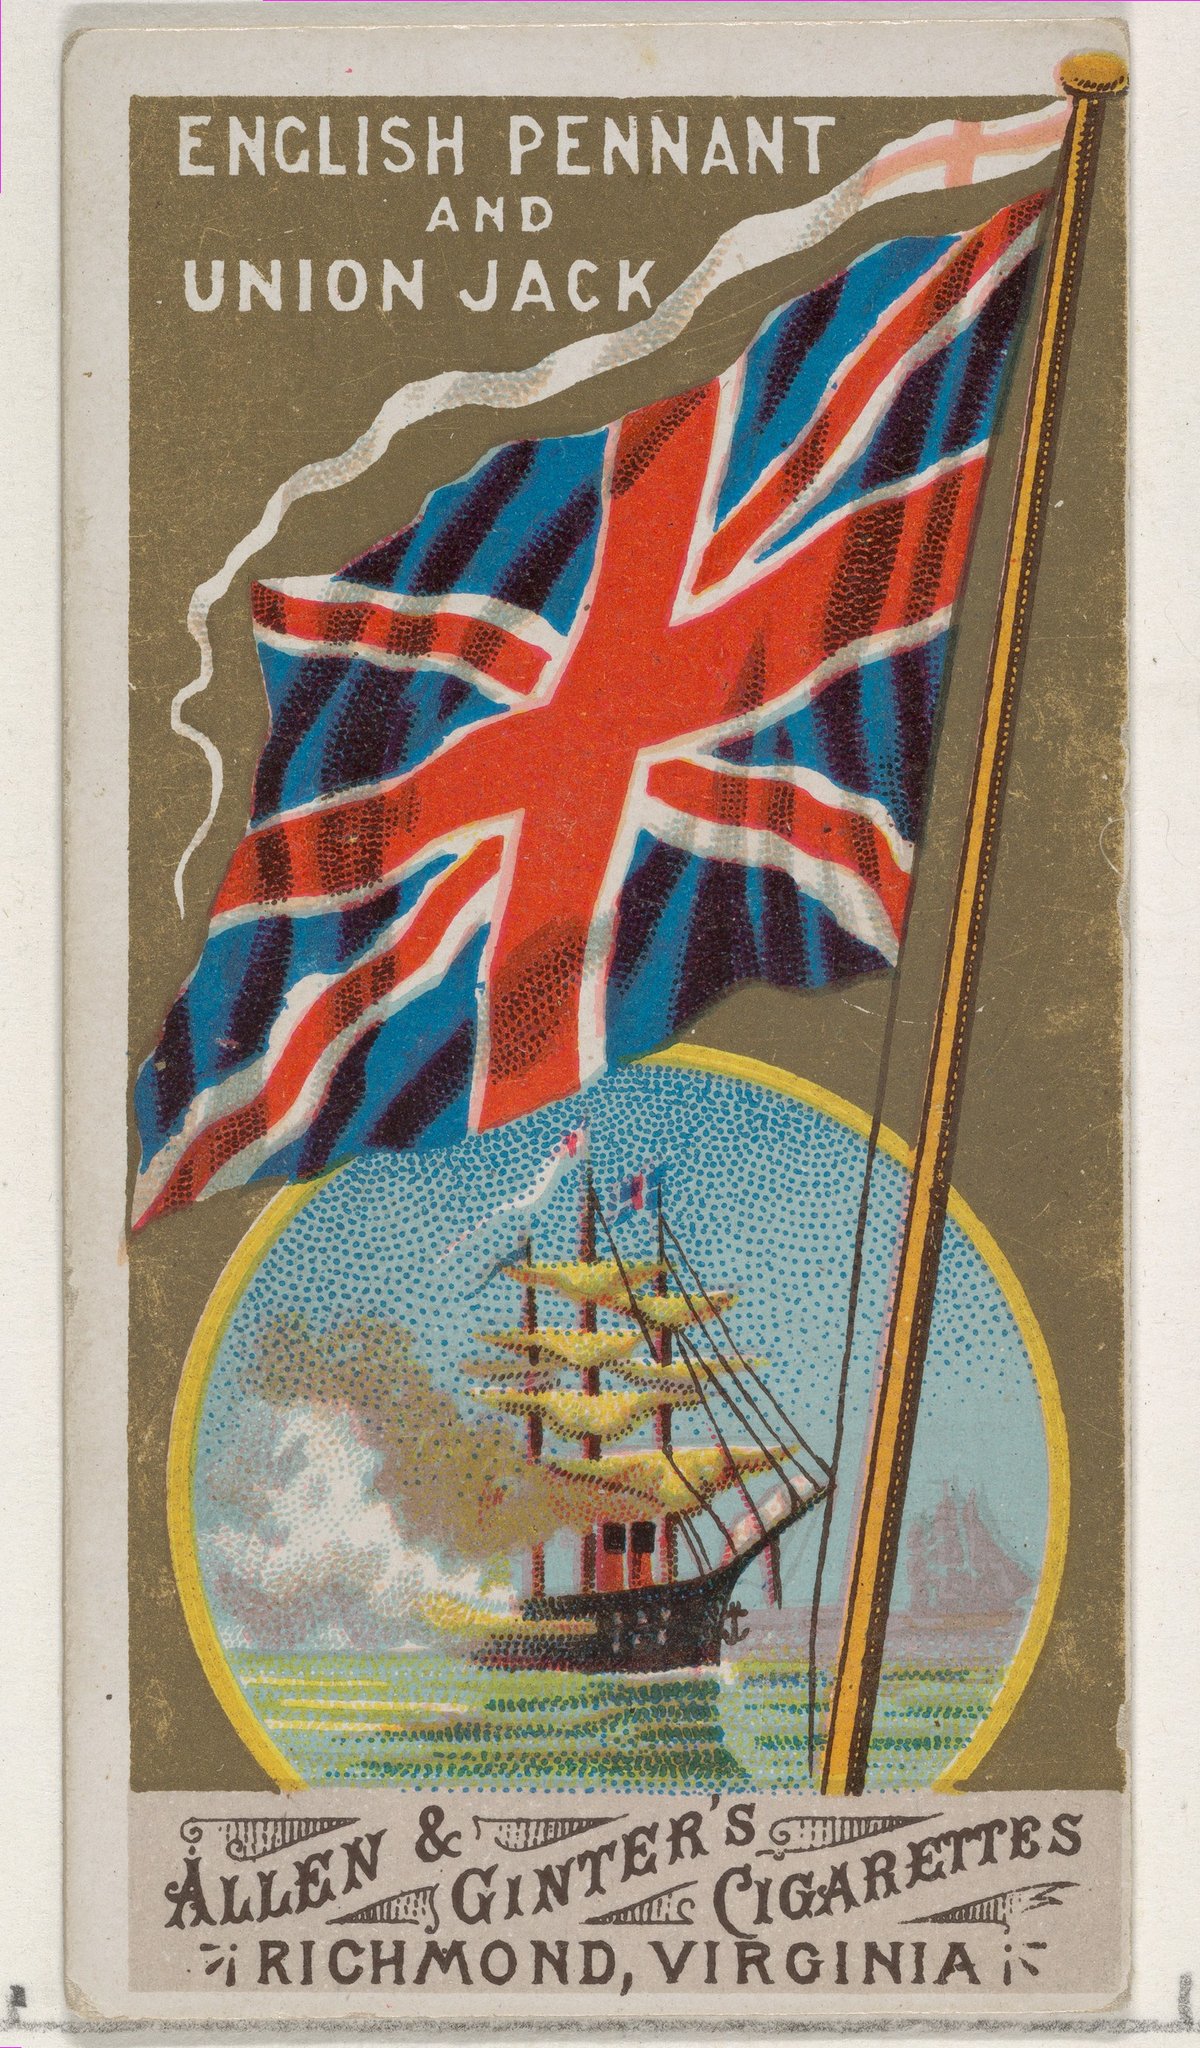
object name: print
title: Royal Standard, Great Britain, from Flags of All Nations, Series 1 (N9) for Allen & Ginter Cigarettes Brands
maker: allen & ginter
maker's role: publisher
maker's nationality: american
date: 1887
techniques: color lithograph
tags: flags